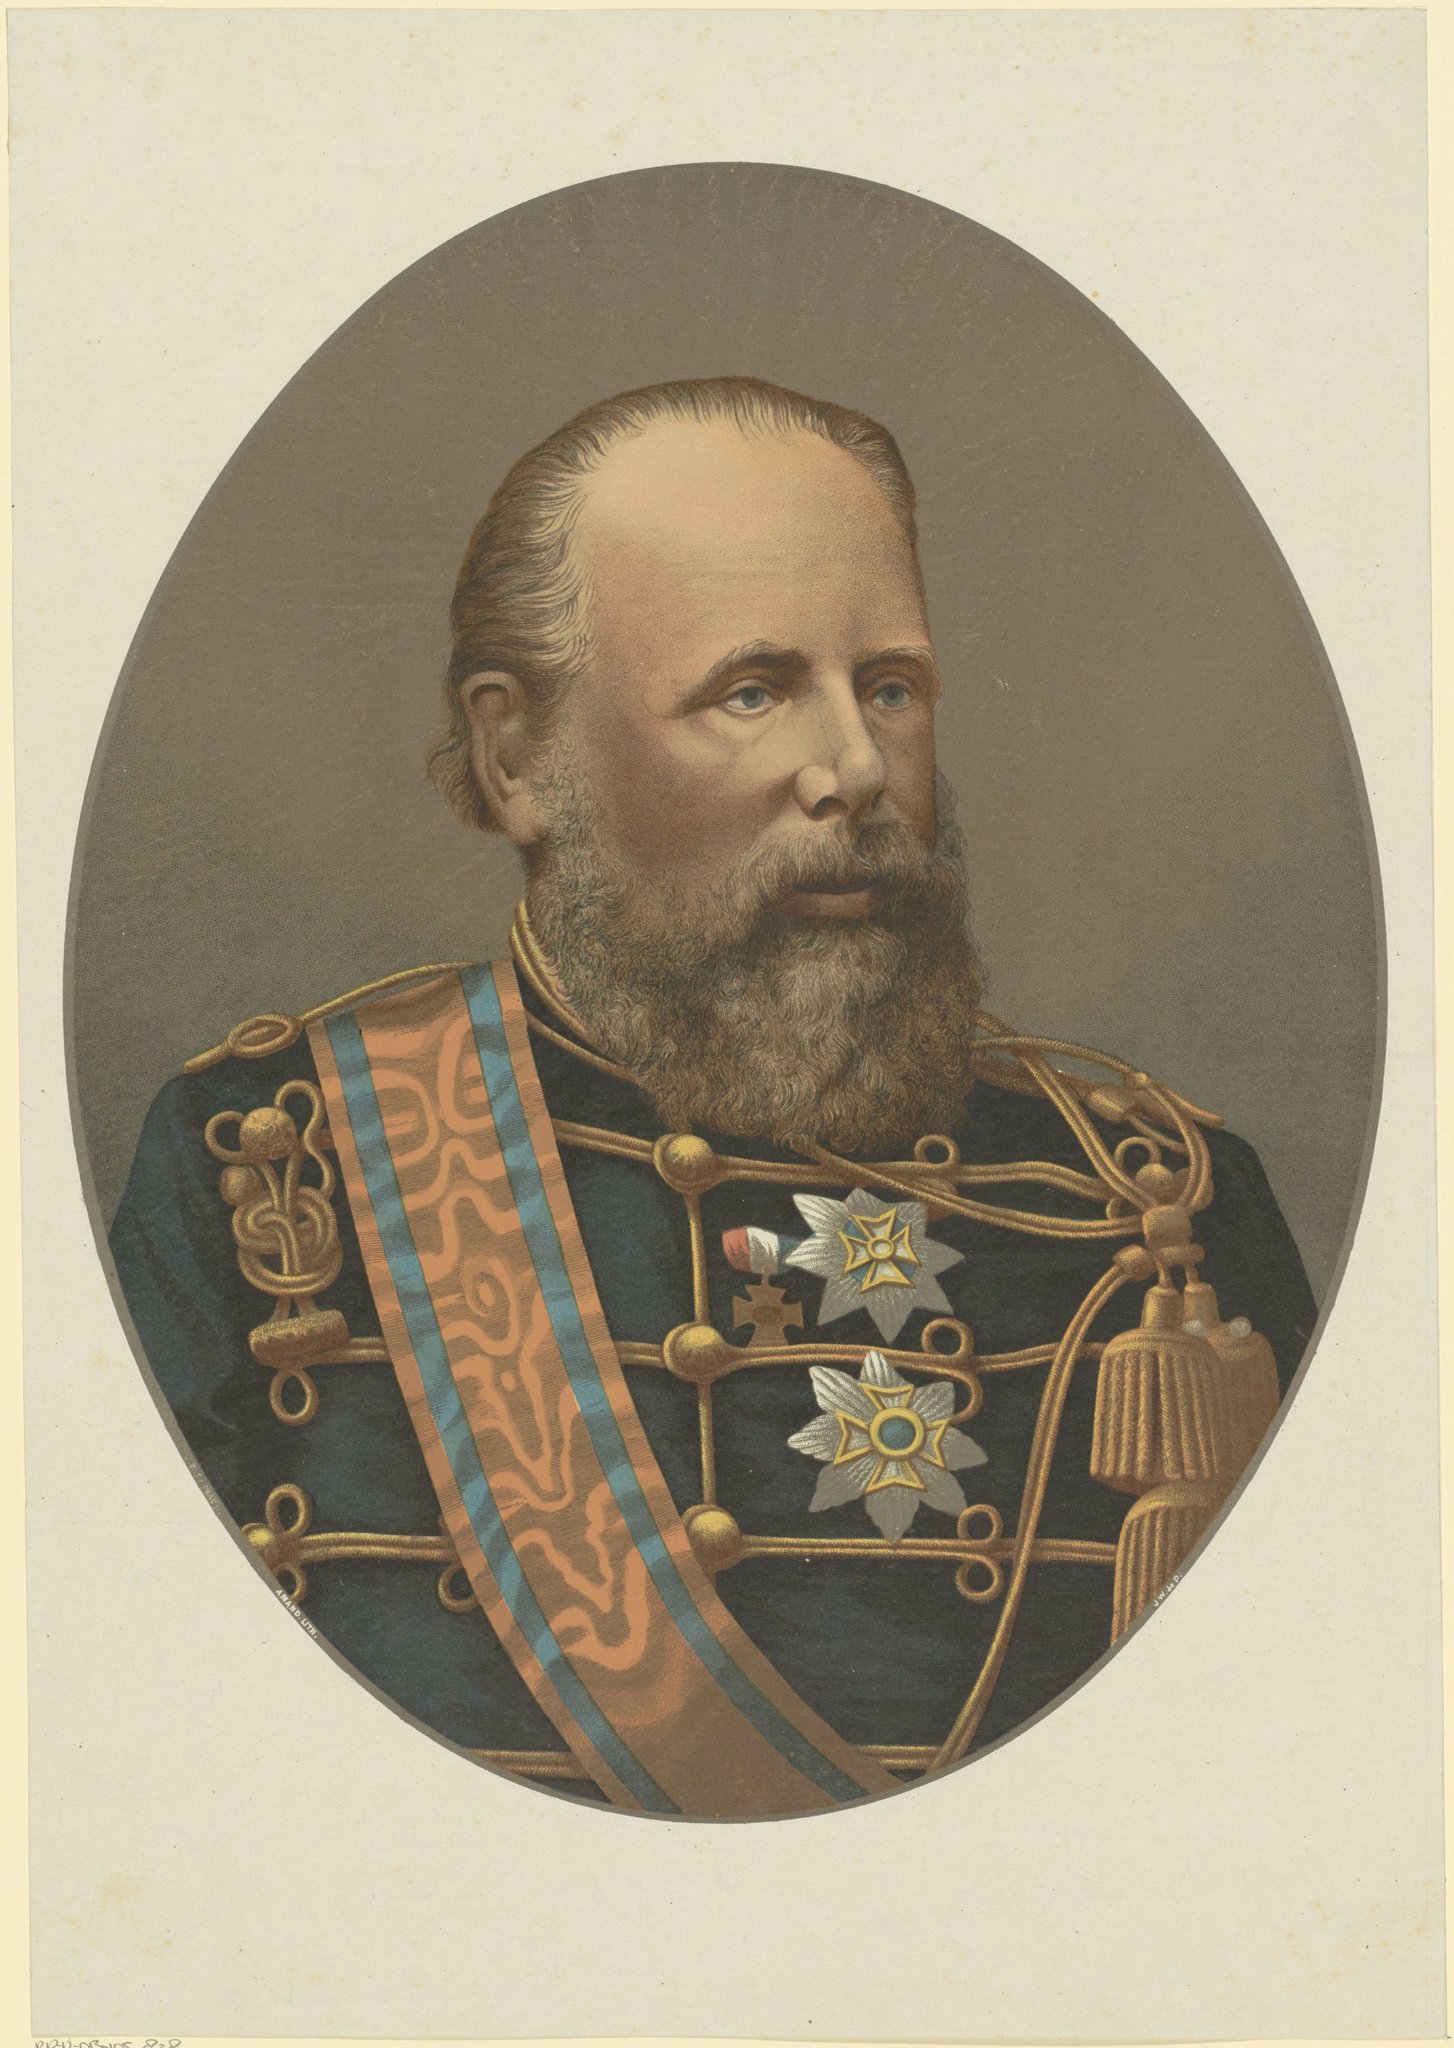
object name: print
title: Portret van Willem III, koning der Nederlanden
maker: monogrammist jw de p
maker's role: print maker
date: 1849-1899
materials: paper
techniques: lithograph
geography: netherlands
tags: brussels, willem iii (koning der nederlanden)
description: De hier vermelde titel verwijst naar de hoogst verkregen titel van de geportretteerde, niet per se naar de titel die de geportretteerde op deze voorstelling draagt.